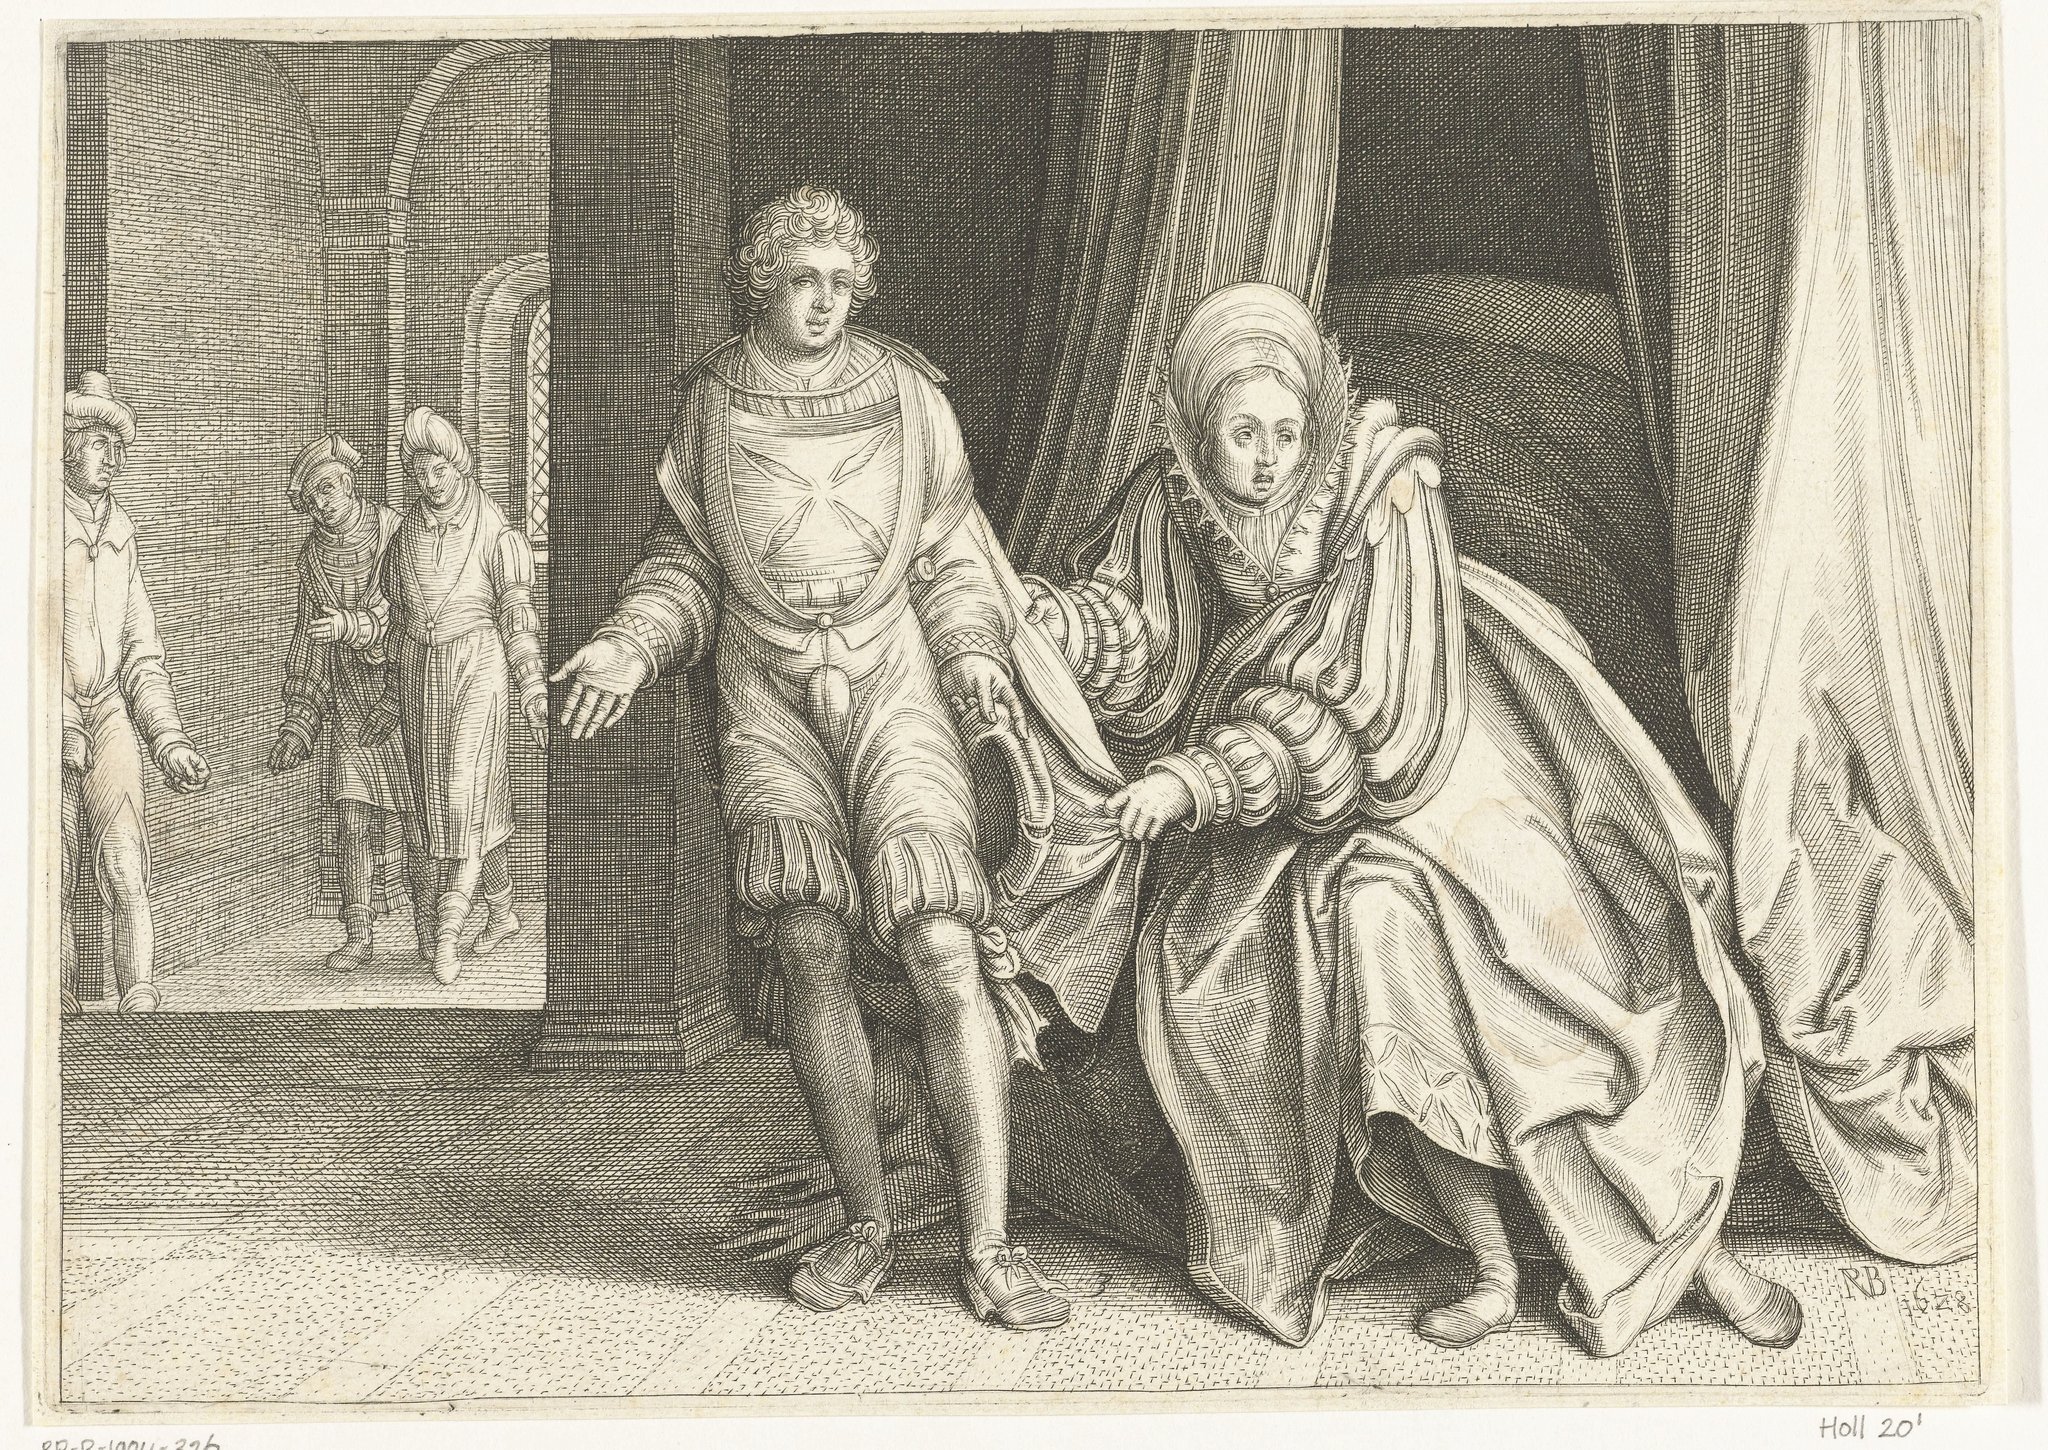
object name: print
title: Jozef en de vrouw van Potifar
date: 1628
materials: paper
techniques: engraving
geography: netherlands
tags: potiphar's wife trying to seduce joseph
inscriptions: collector's mark: Lugt 2228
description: Prent uit serie van zes prenten met het verhaal van Jozef. De serie is geïnspireerd op een vergelijkbare reeks van Lucas van Leyden.